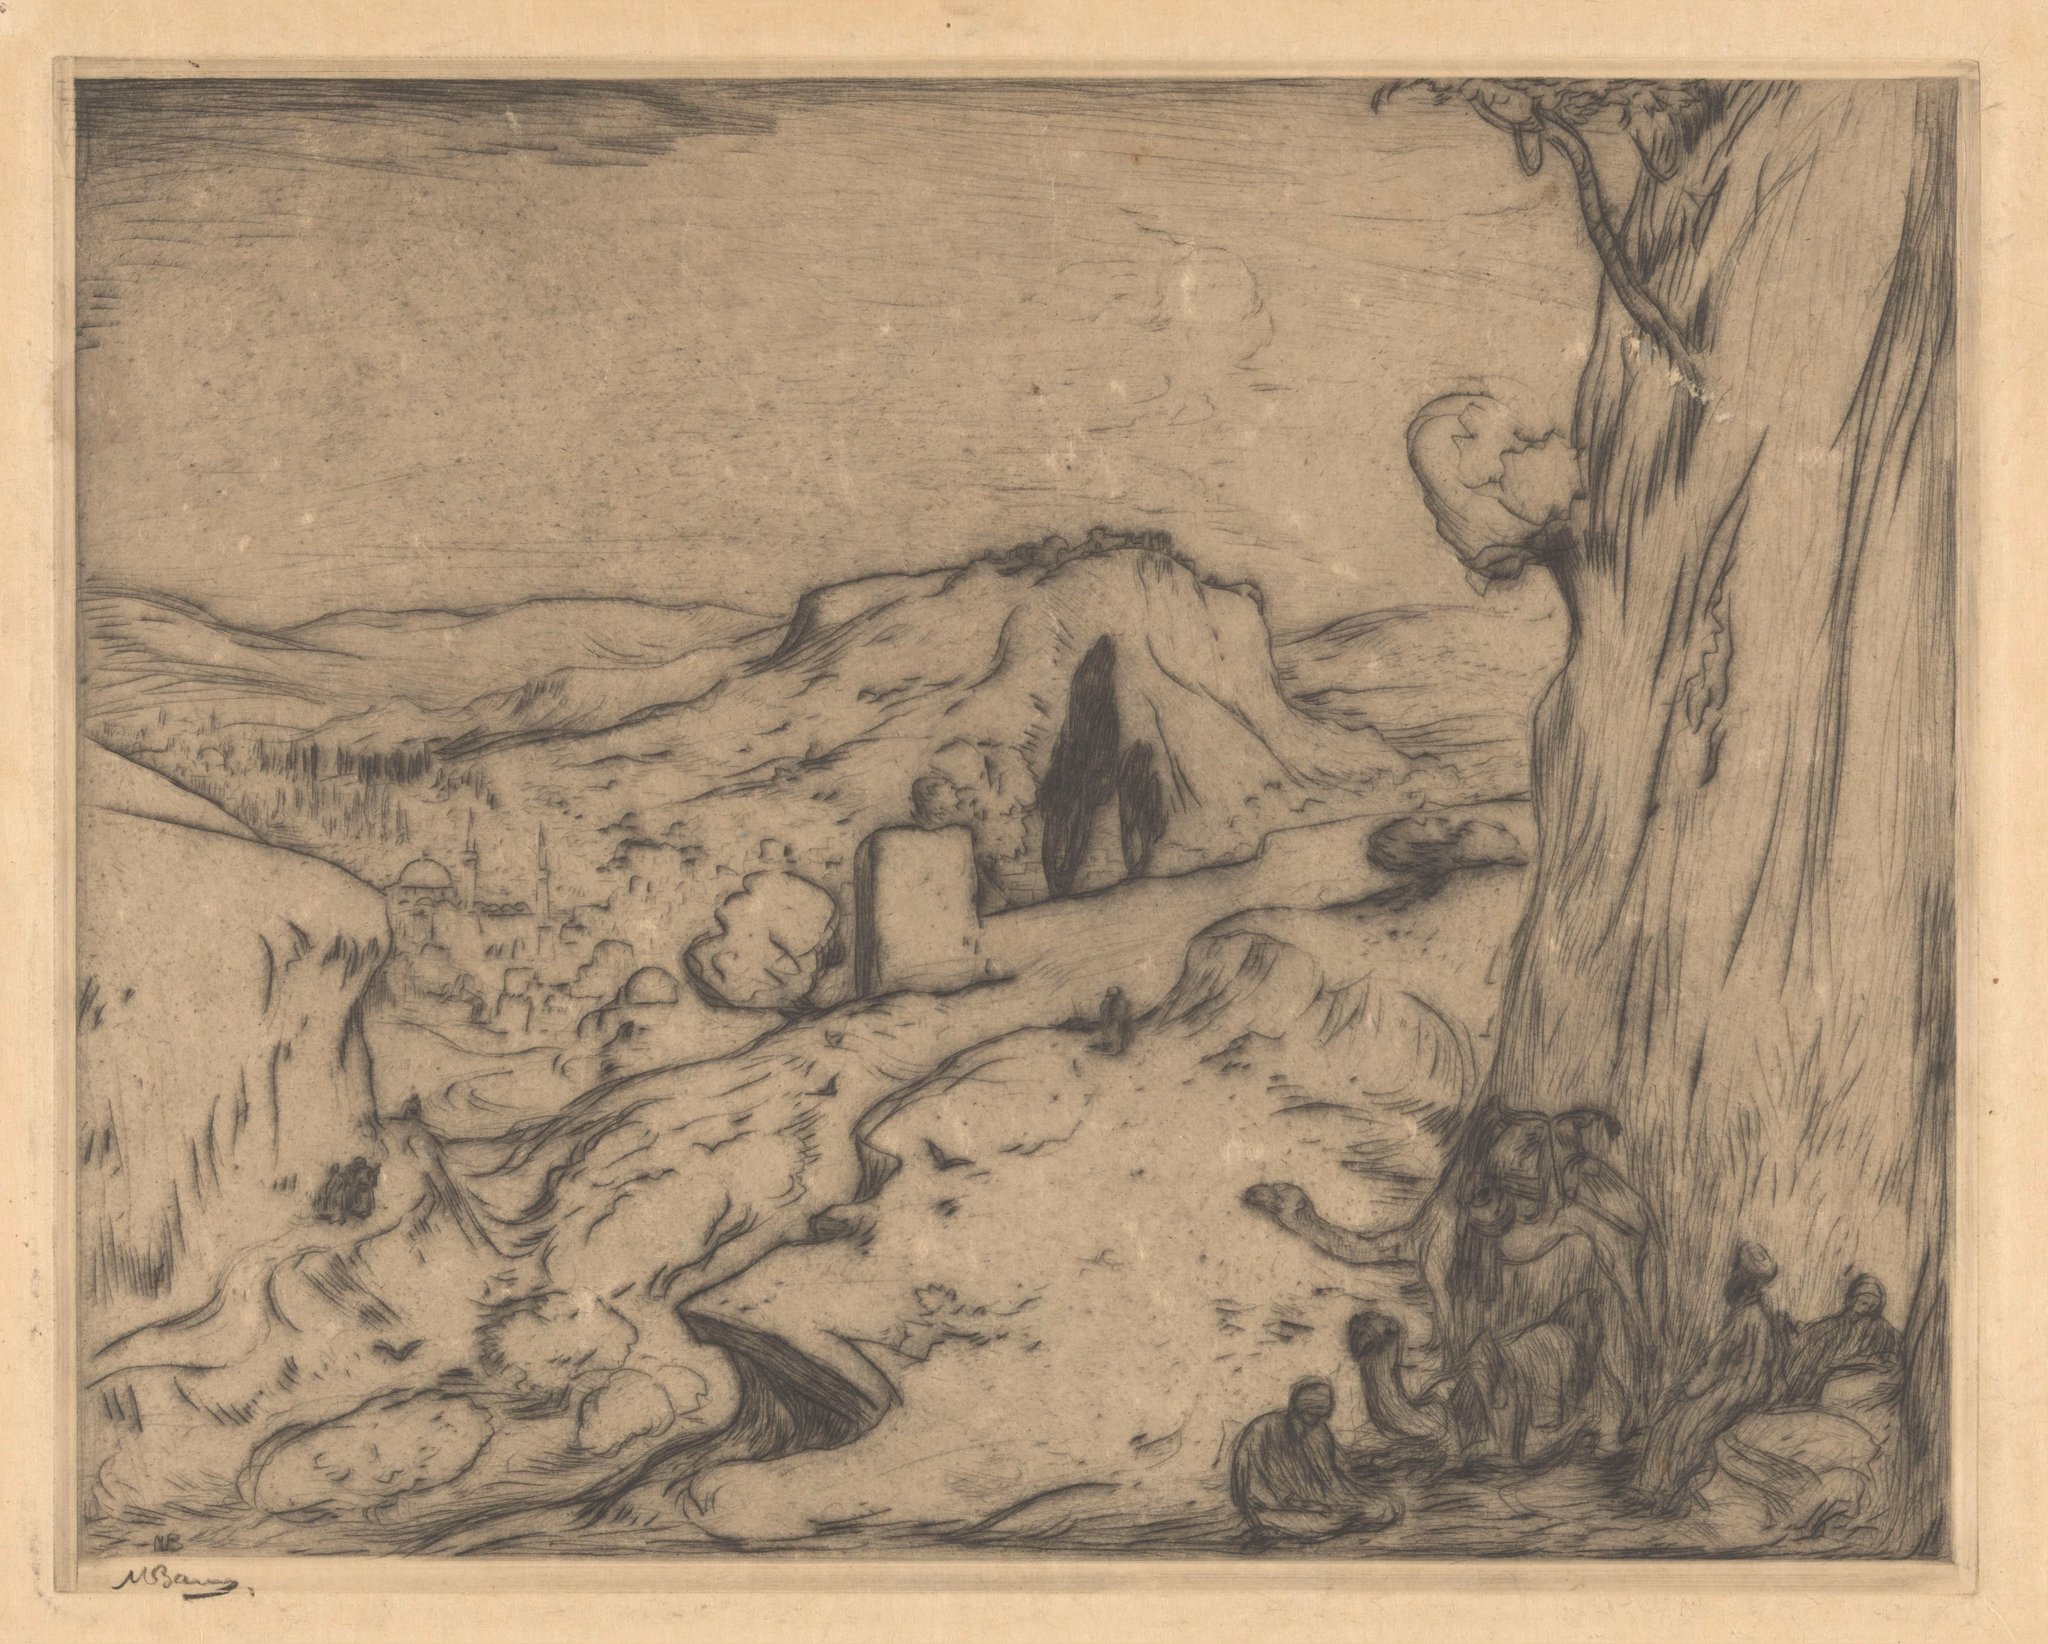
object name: print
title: Gezicht op een oosterse stad in een dal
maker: marius bauer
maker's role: draughtsman, print maker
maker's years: 1867-1932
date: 1877-1932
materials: paper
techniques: etching, intaglio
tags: hoofed animals: camel, city-view, and landscape with man-made constructions, temple, shrine ~ islam, mohammedanism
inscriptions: collector's mark: Lugt 2760, collector's mark: Lugt 2228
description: Een gezicht op een stad met een moskee met twee minaretten, gelegen in een dal. Rechts op de voorgrond een groep figuren met twee kamelen voor een steile helling.